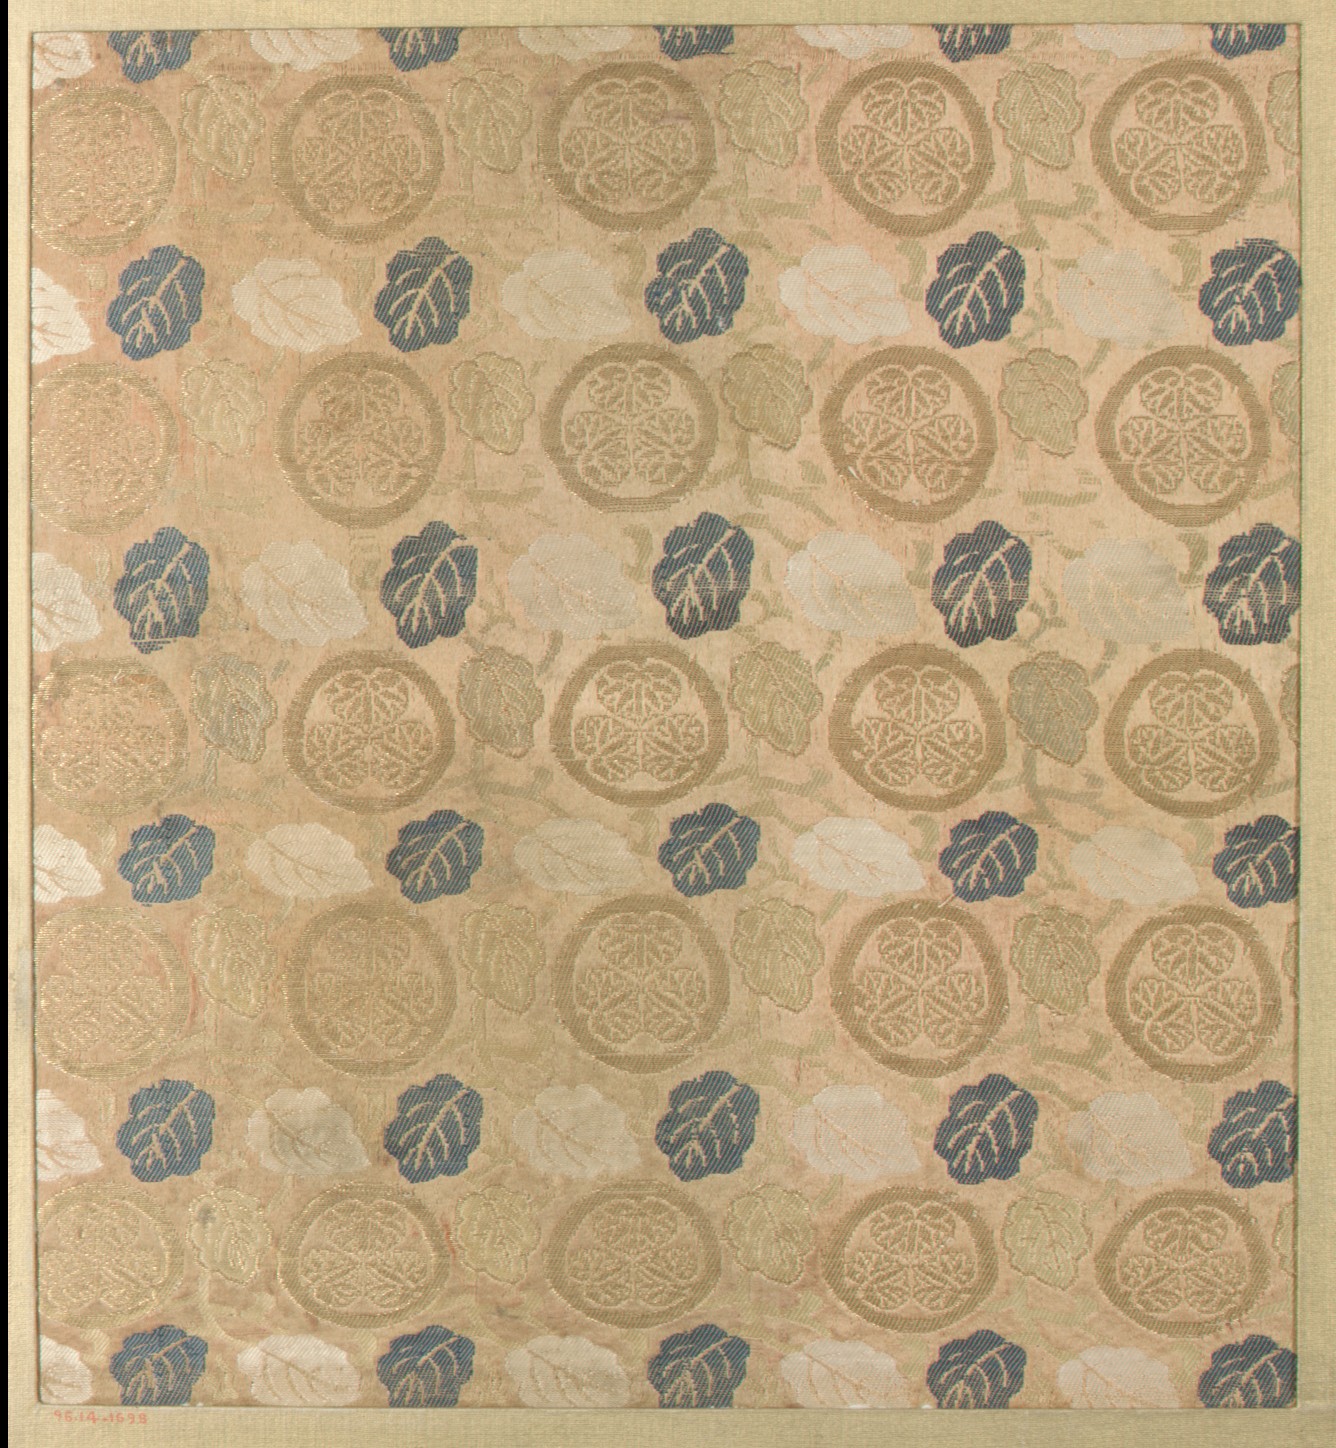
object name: piece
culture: japanese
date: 1701-1900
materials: silk